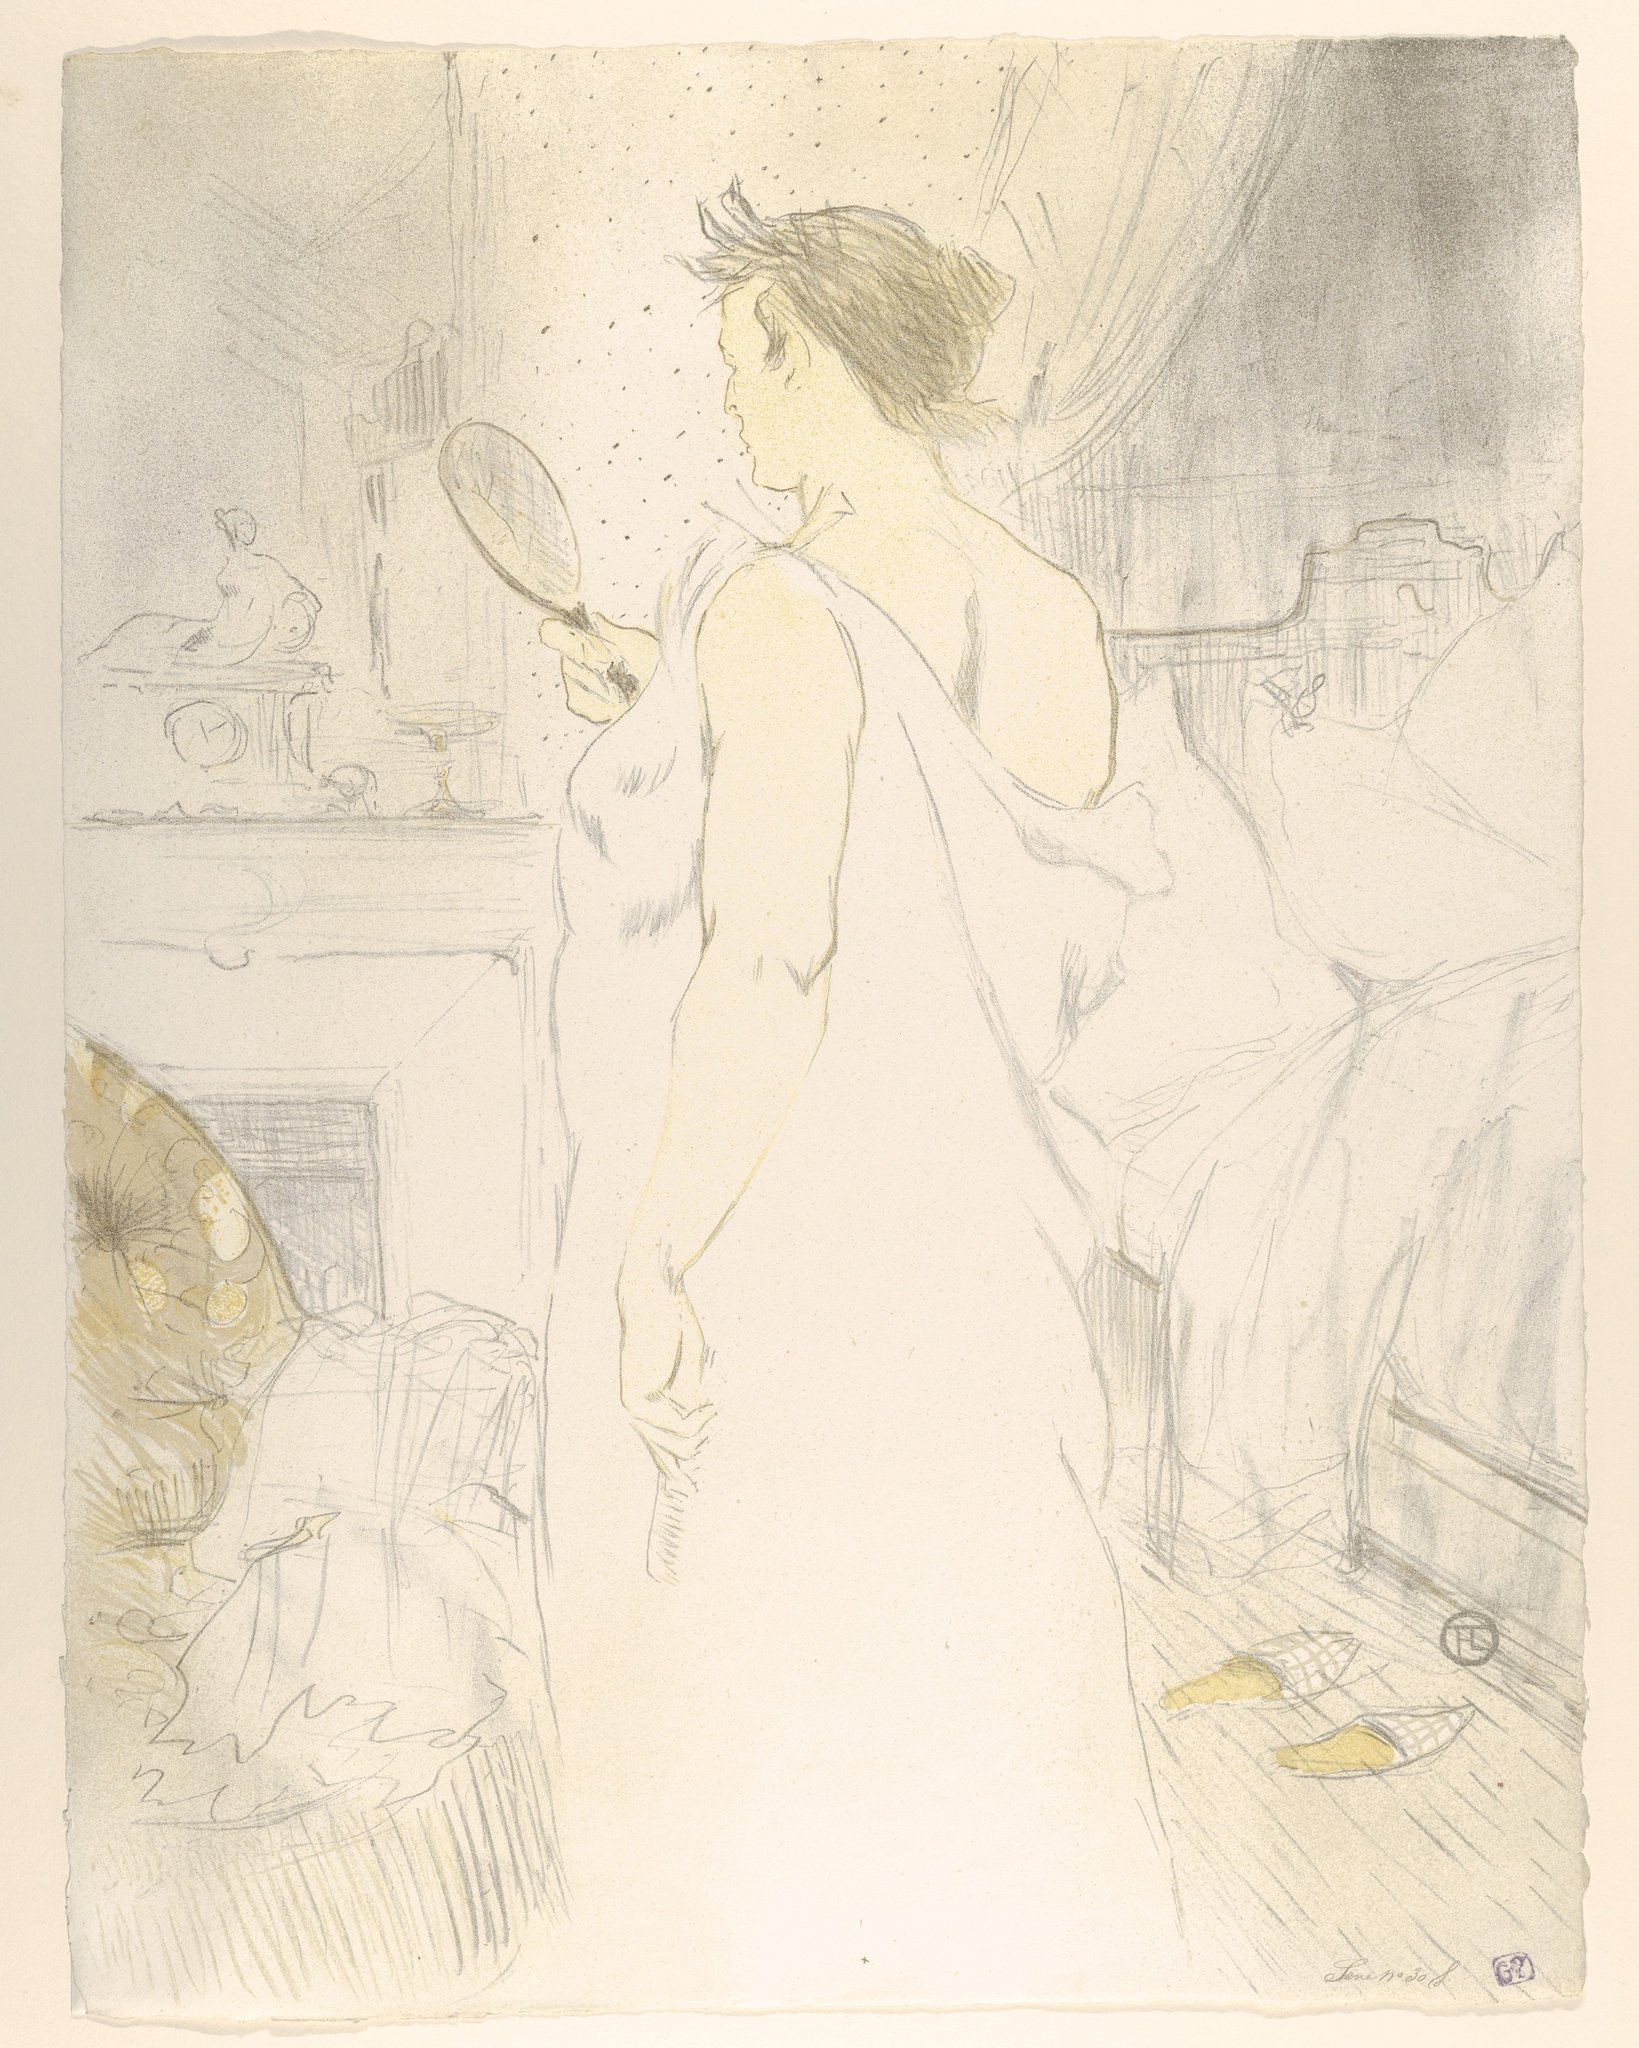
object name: print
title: Looking in a Mirror, from "Elles"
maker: henri de toulouse-lautrec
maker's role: artist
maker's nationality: french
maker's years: 1864-1901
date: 1896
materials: crayon, paper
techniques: brush, lithograph, printing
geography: france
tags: women,mirrors